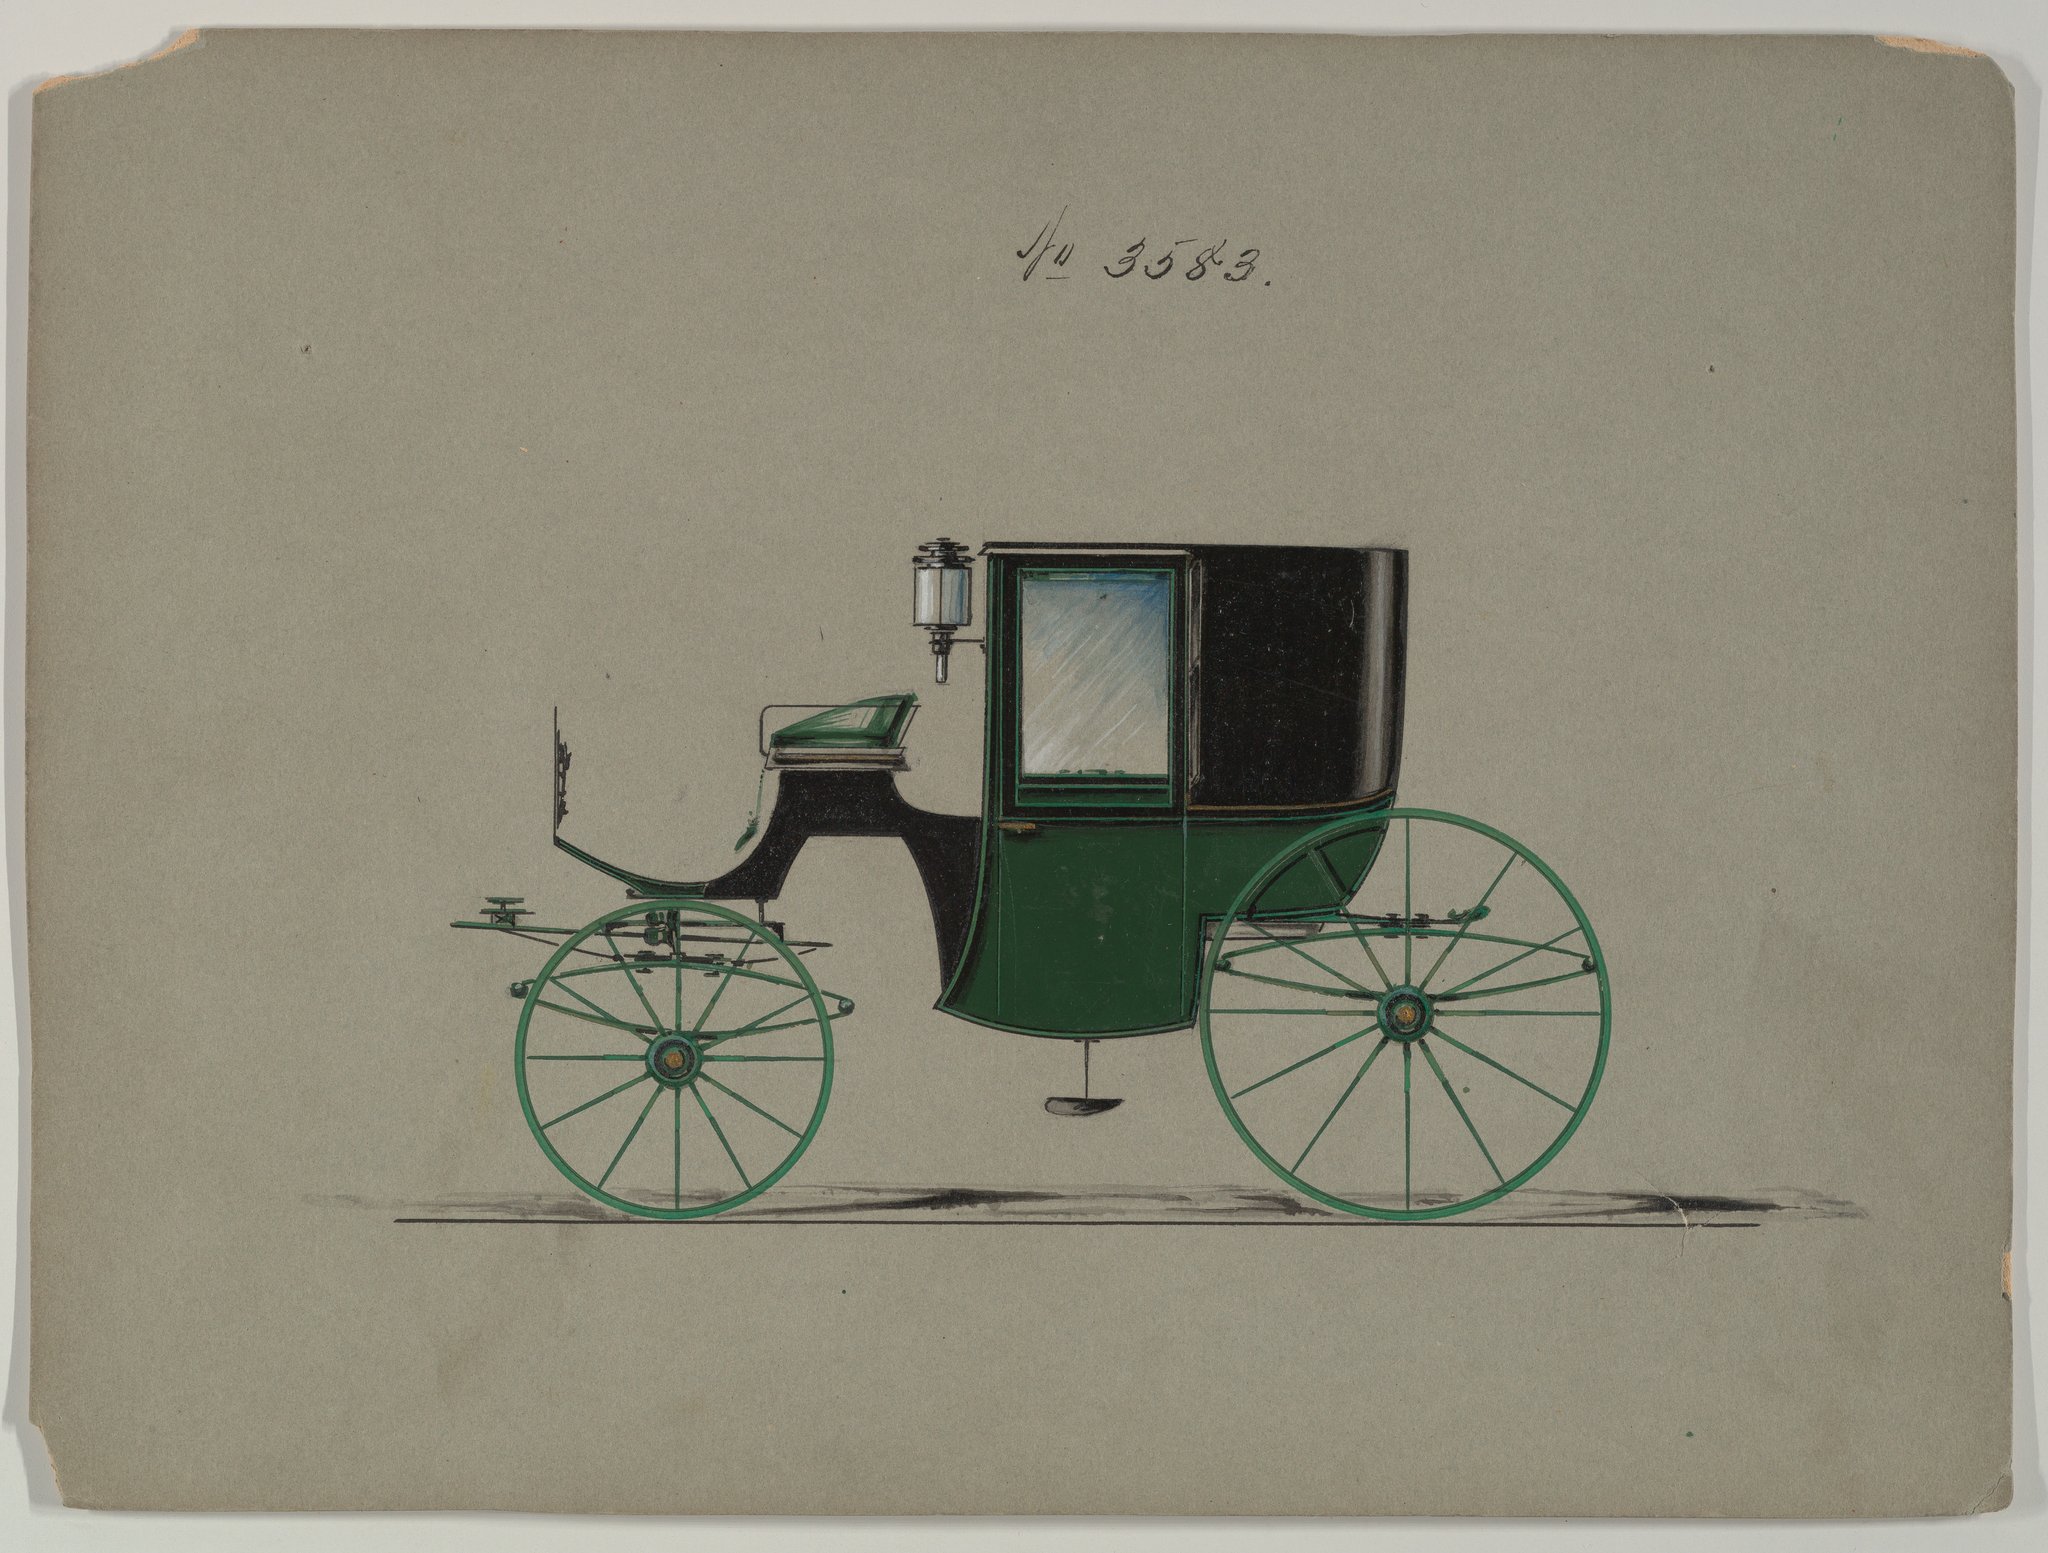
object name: drawing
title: Brougham #3583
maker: brewster & co.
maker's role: manufacturer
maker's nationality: american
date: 1879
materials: gouache, ink, watercolor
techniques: pen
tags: carriages